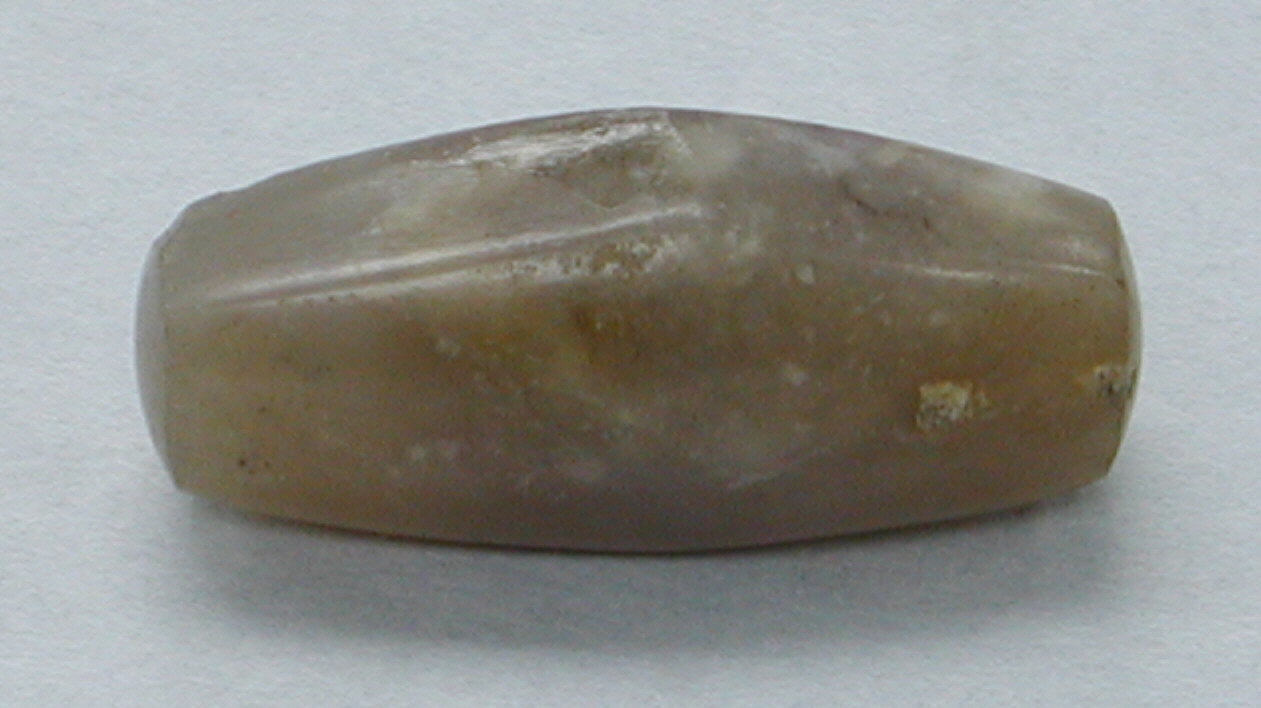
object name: ritual stone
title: Stone Pulidor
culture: mexican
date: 1501-1600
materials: stone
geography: mexico